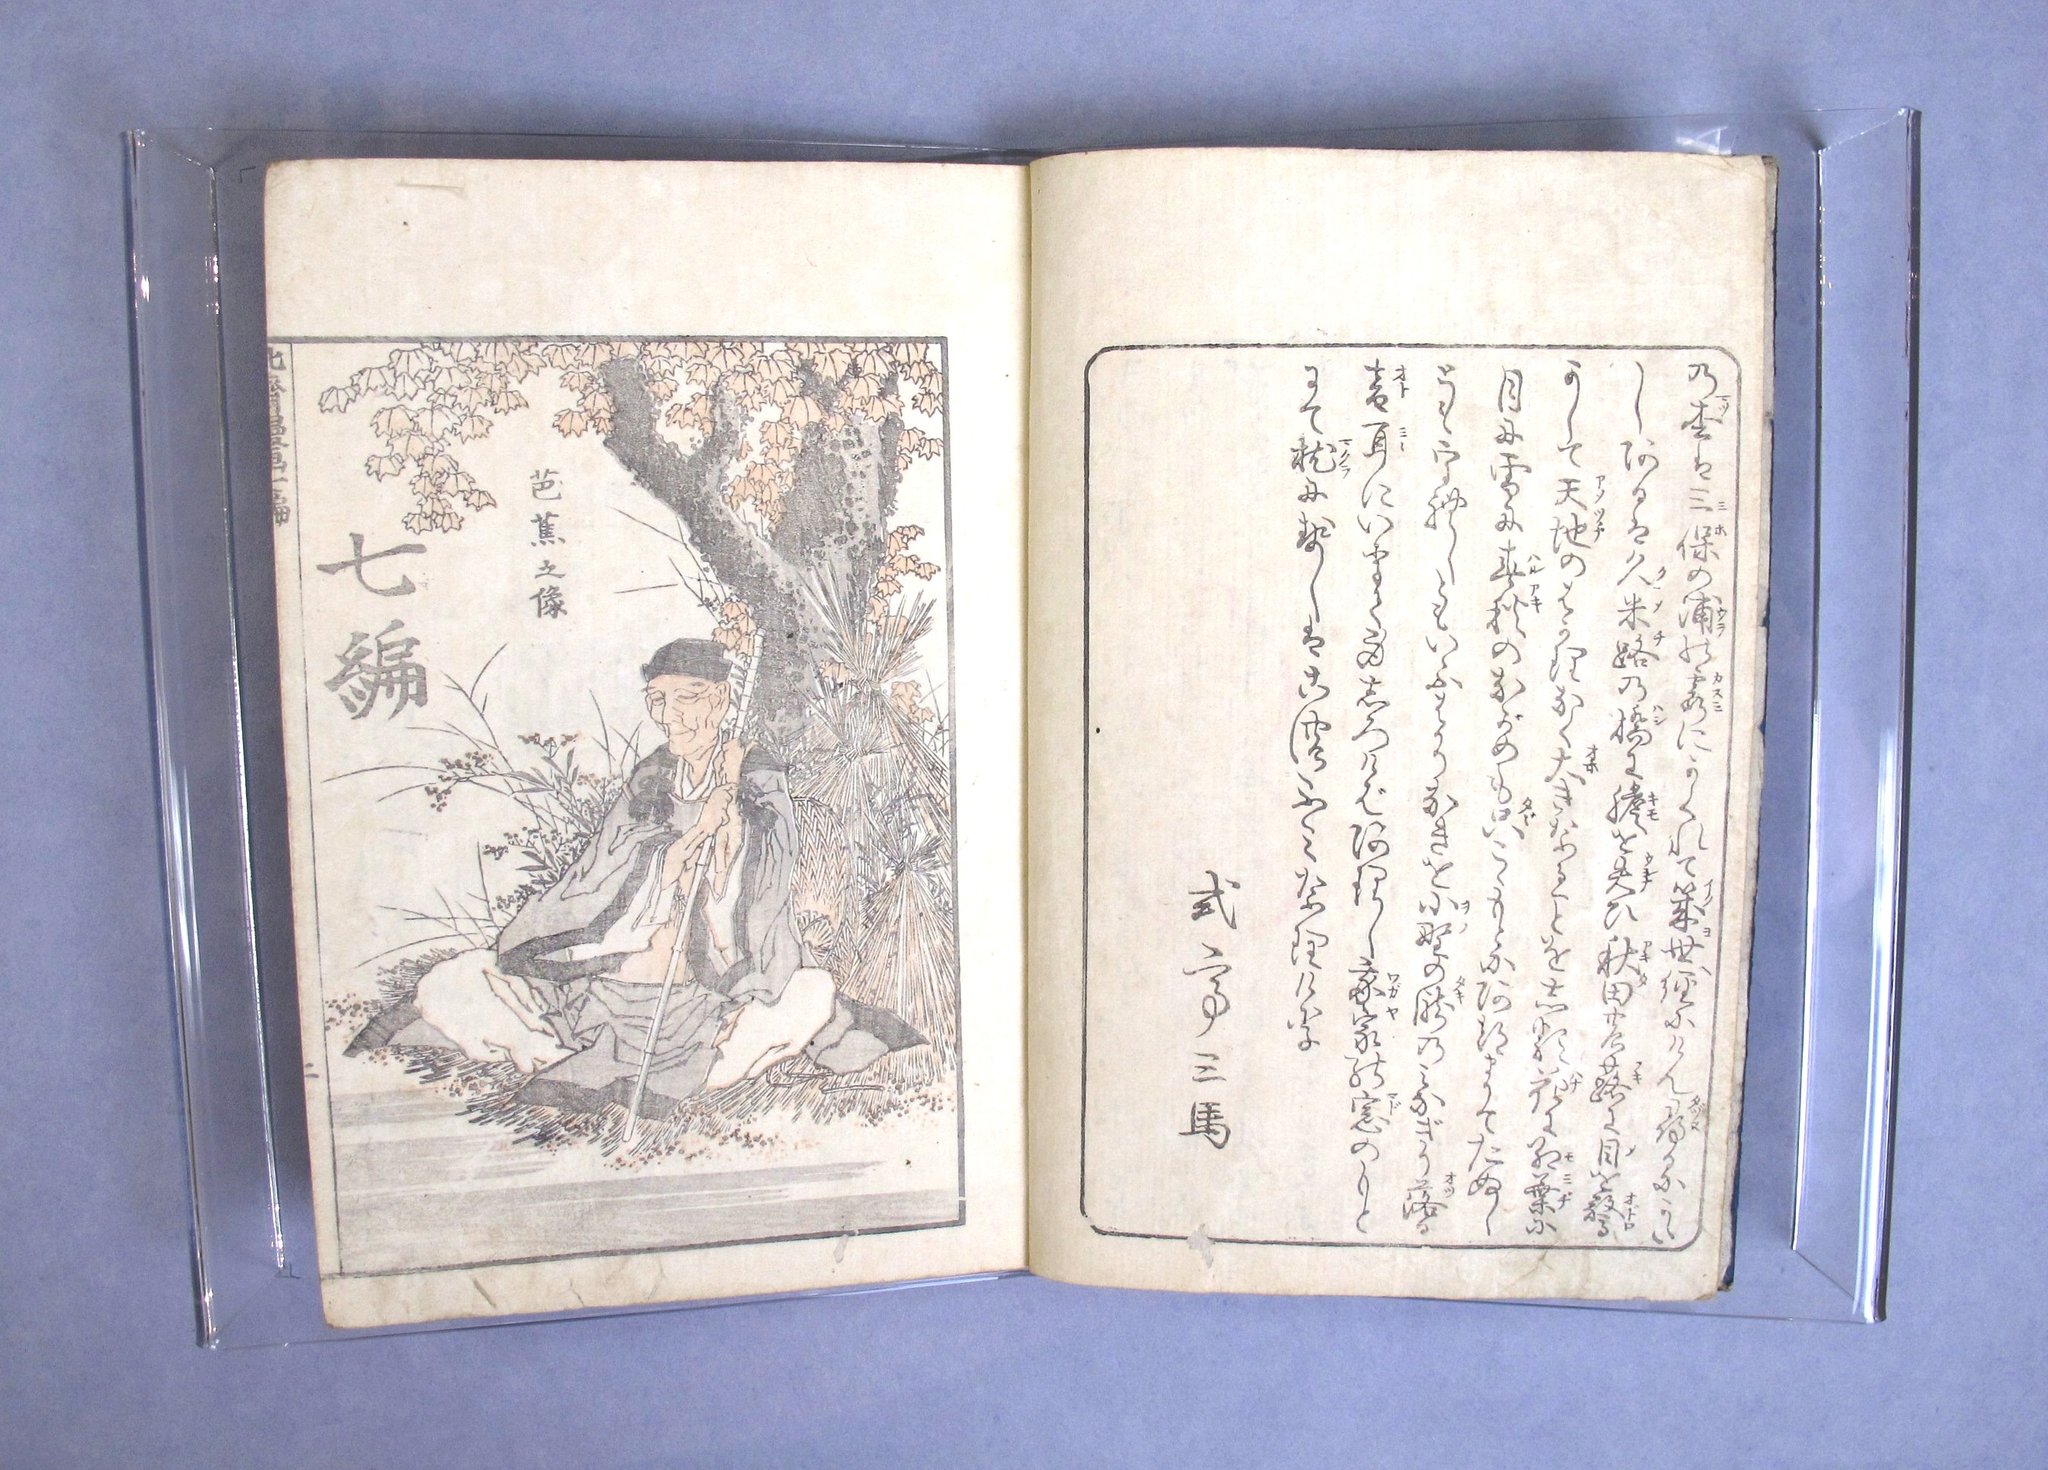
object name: illustrated book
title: Transmitting the Spirit, Revealing the Form of Things: Hokusai Sketchbooks, volume 7 (Denshin kaishu: Hokusai manga, nanahen)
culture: japanese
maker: katsushika hokusai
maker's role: artist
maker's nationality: japanese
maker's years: 1760-1849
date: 1819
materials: ink, paper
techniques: woodblock print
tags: men